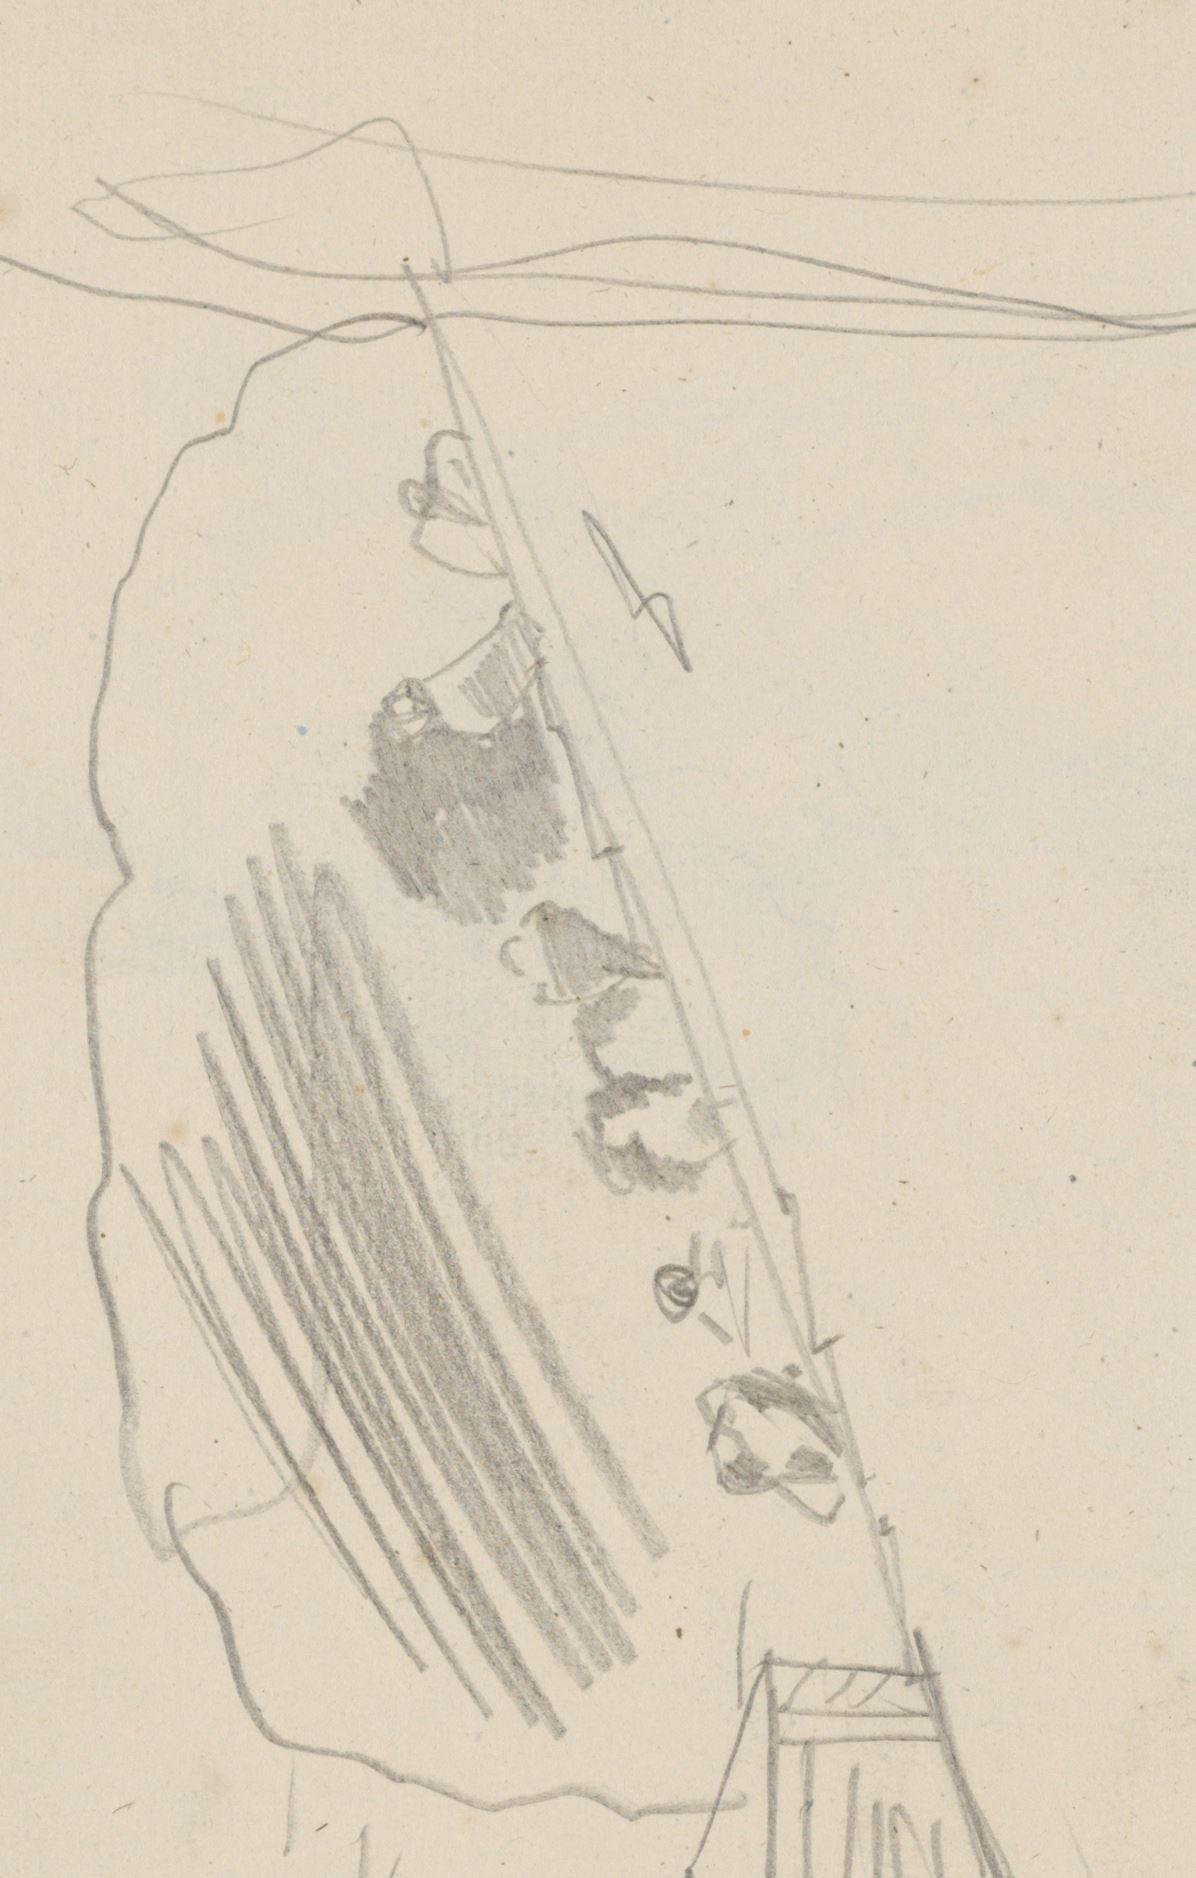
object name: sketchbook leaf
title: Dak met wolkenlucht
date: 1880-1882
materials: paper, pencil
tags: roof (of house or building), clouds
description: Pagina 27 uit een schetsboek met 31 bladen.